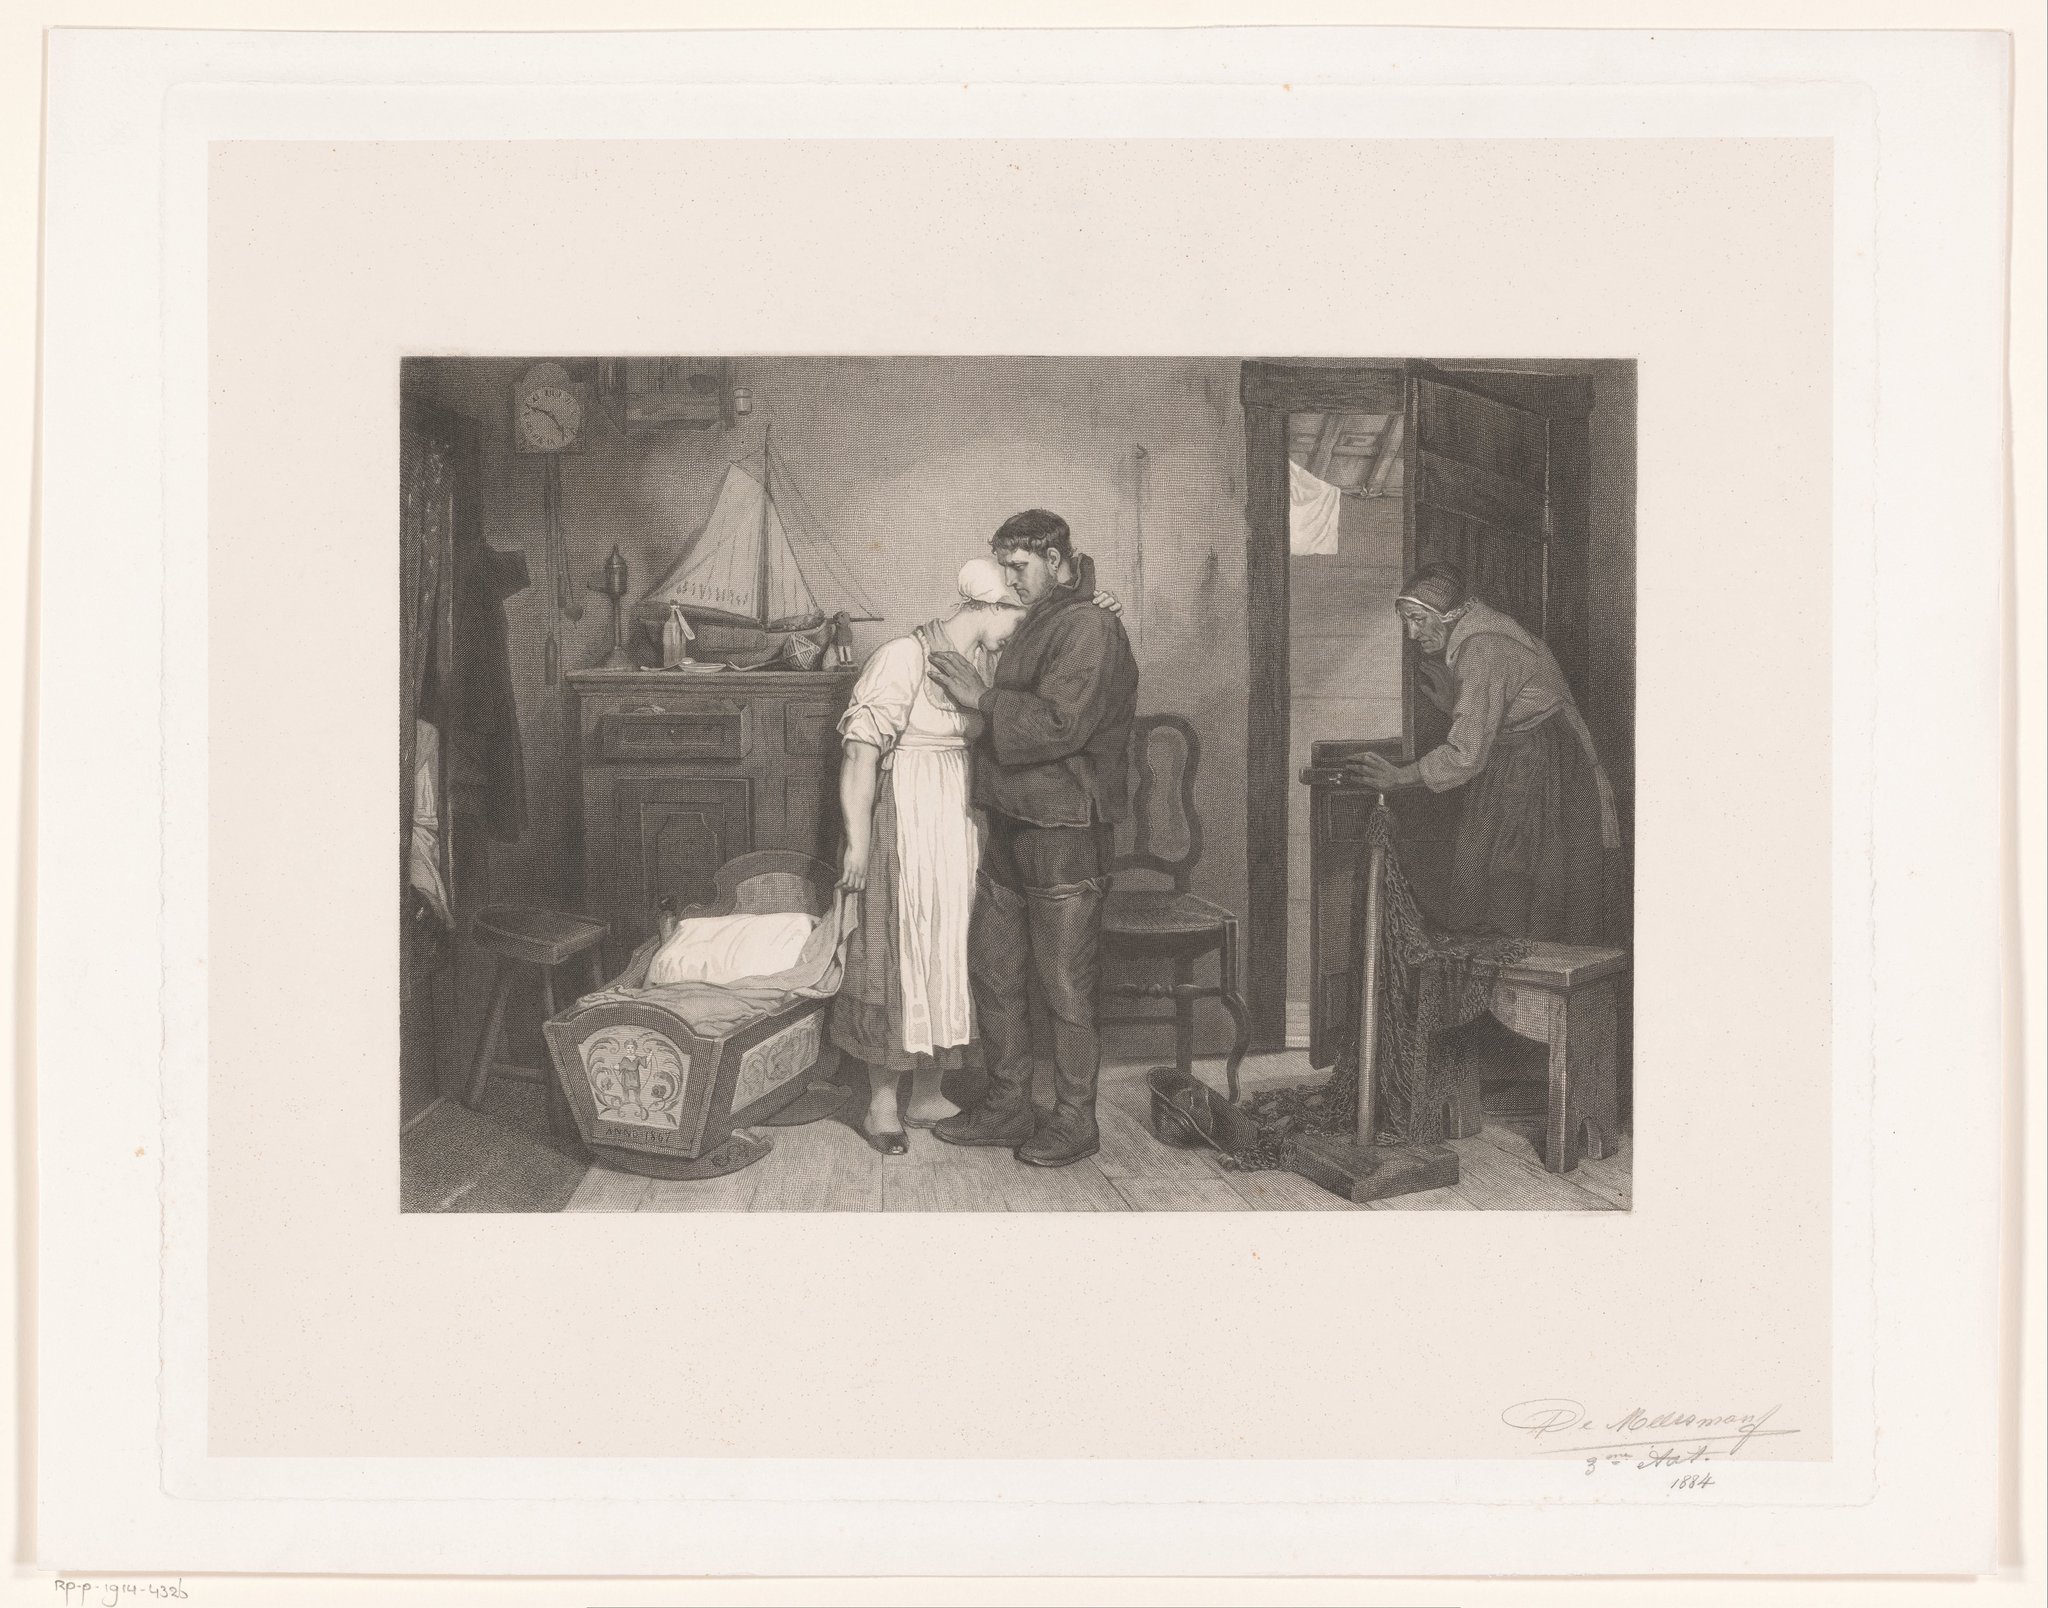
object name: print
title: Vissersinterieur met treurend koppel bij een lege wieg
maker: françois de meersman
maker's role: print maker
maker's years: 1830-1905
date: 1884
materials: paper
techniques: engraving, etching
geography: belgium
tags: death of a child, cradle, crib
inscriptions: annotation: ‘3eme état’, collector's mark: Lugt 2228